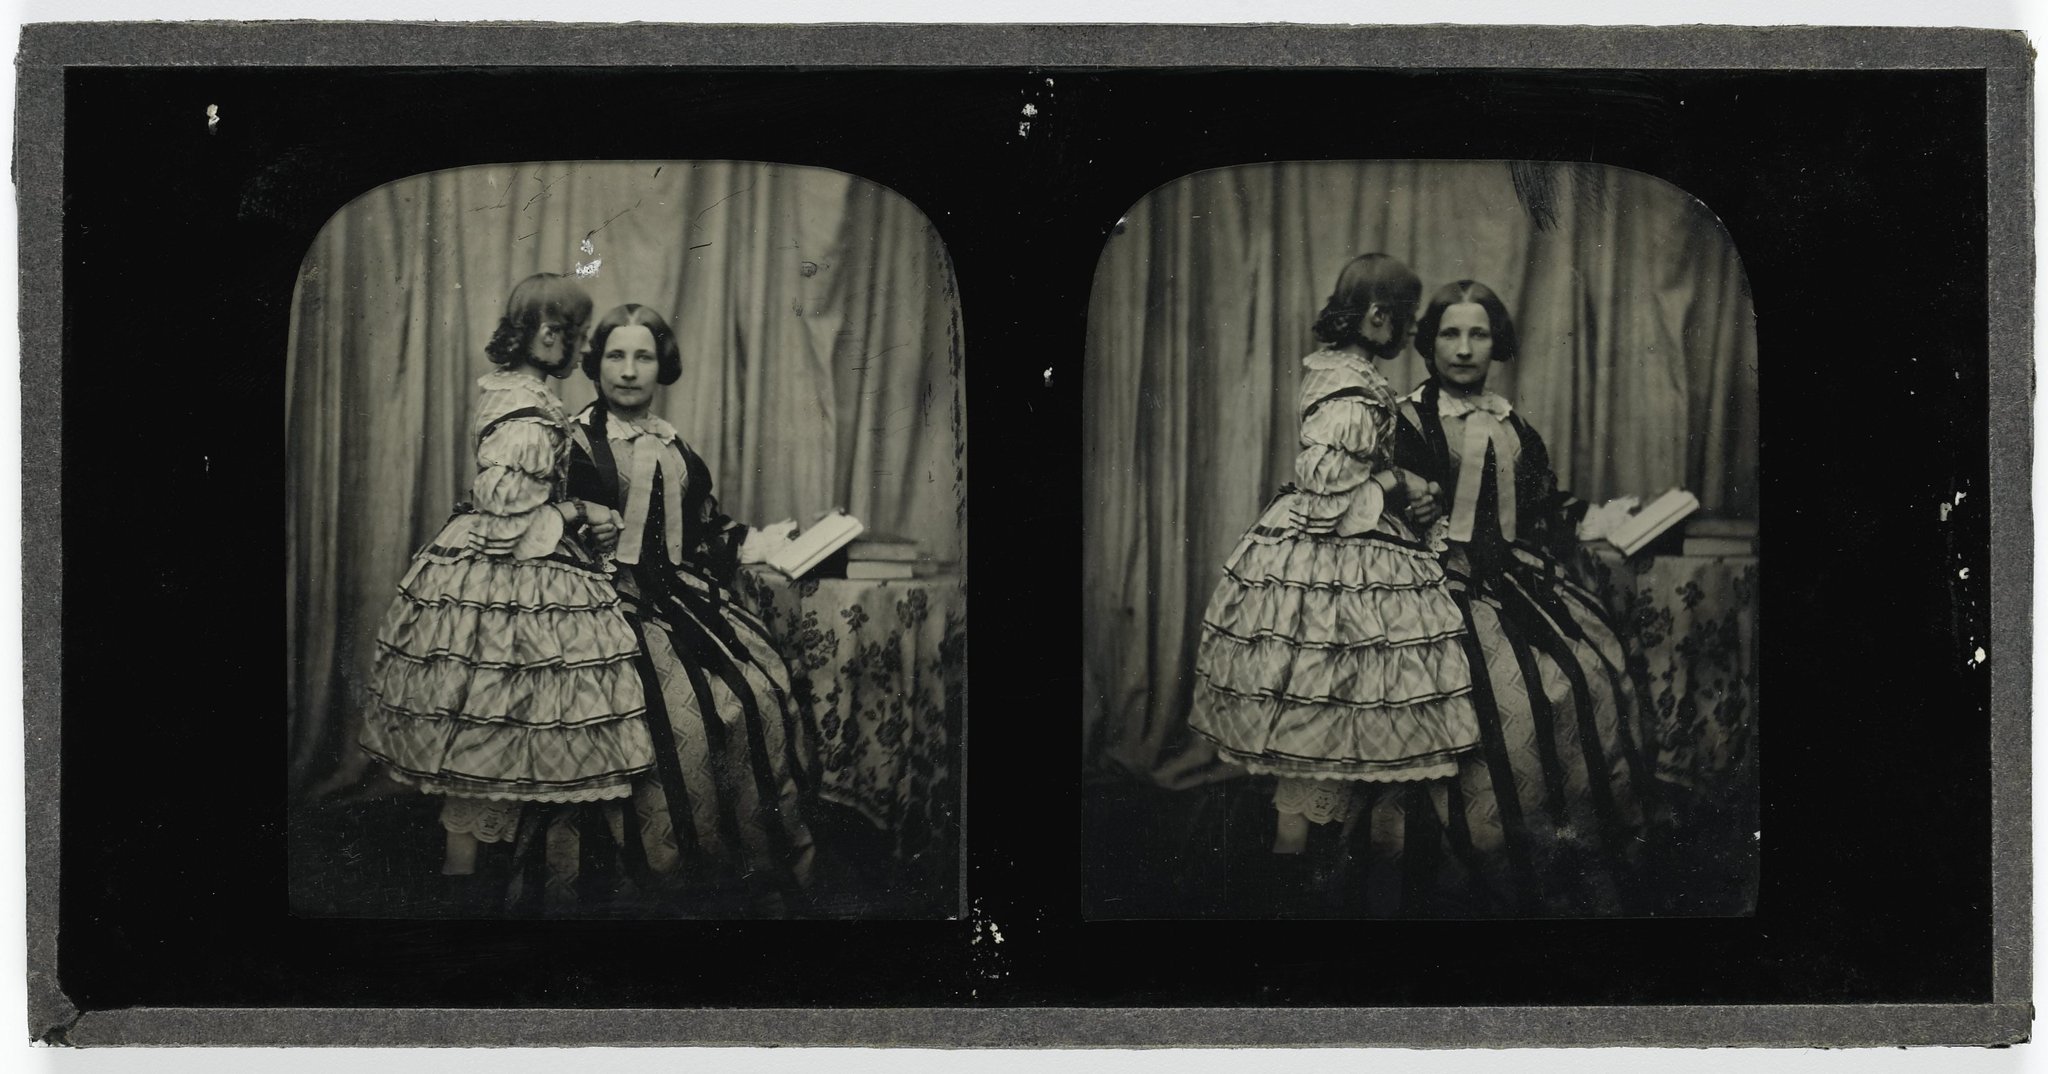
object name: stereograph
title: Dubbelportret van een onbekende zittende vrouw en een onbekend staand meisje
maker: Anonymous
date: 1855-1870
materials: cardboard, glass, paper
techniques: ambrotype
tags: sitting figure - aa - female human figure, historical persons - bb - woman, girl (child between toddler and youth), mother and baby or young child